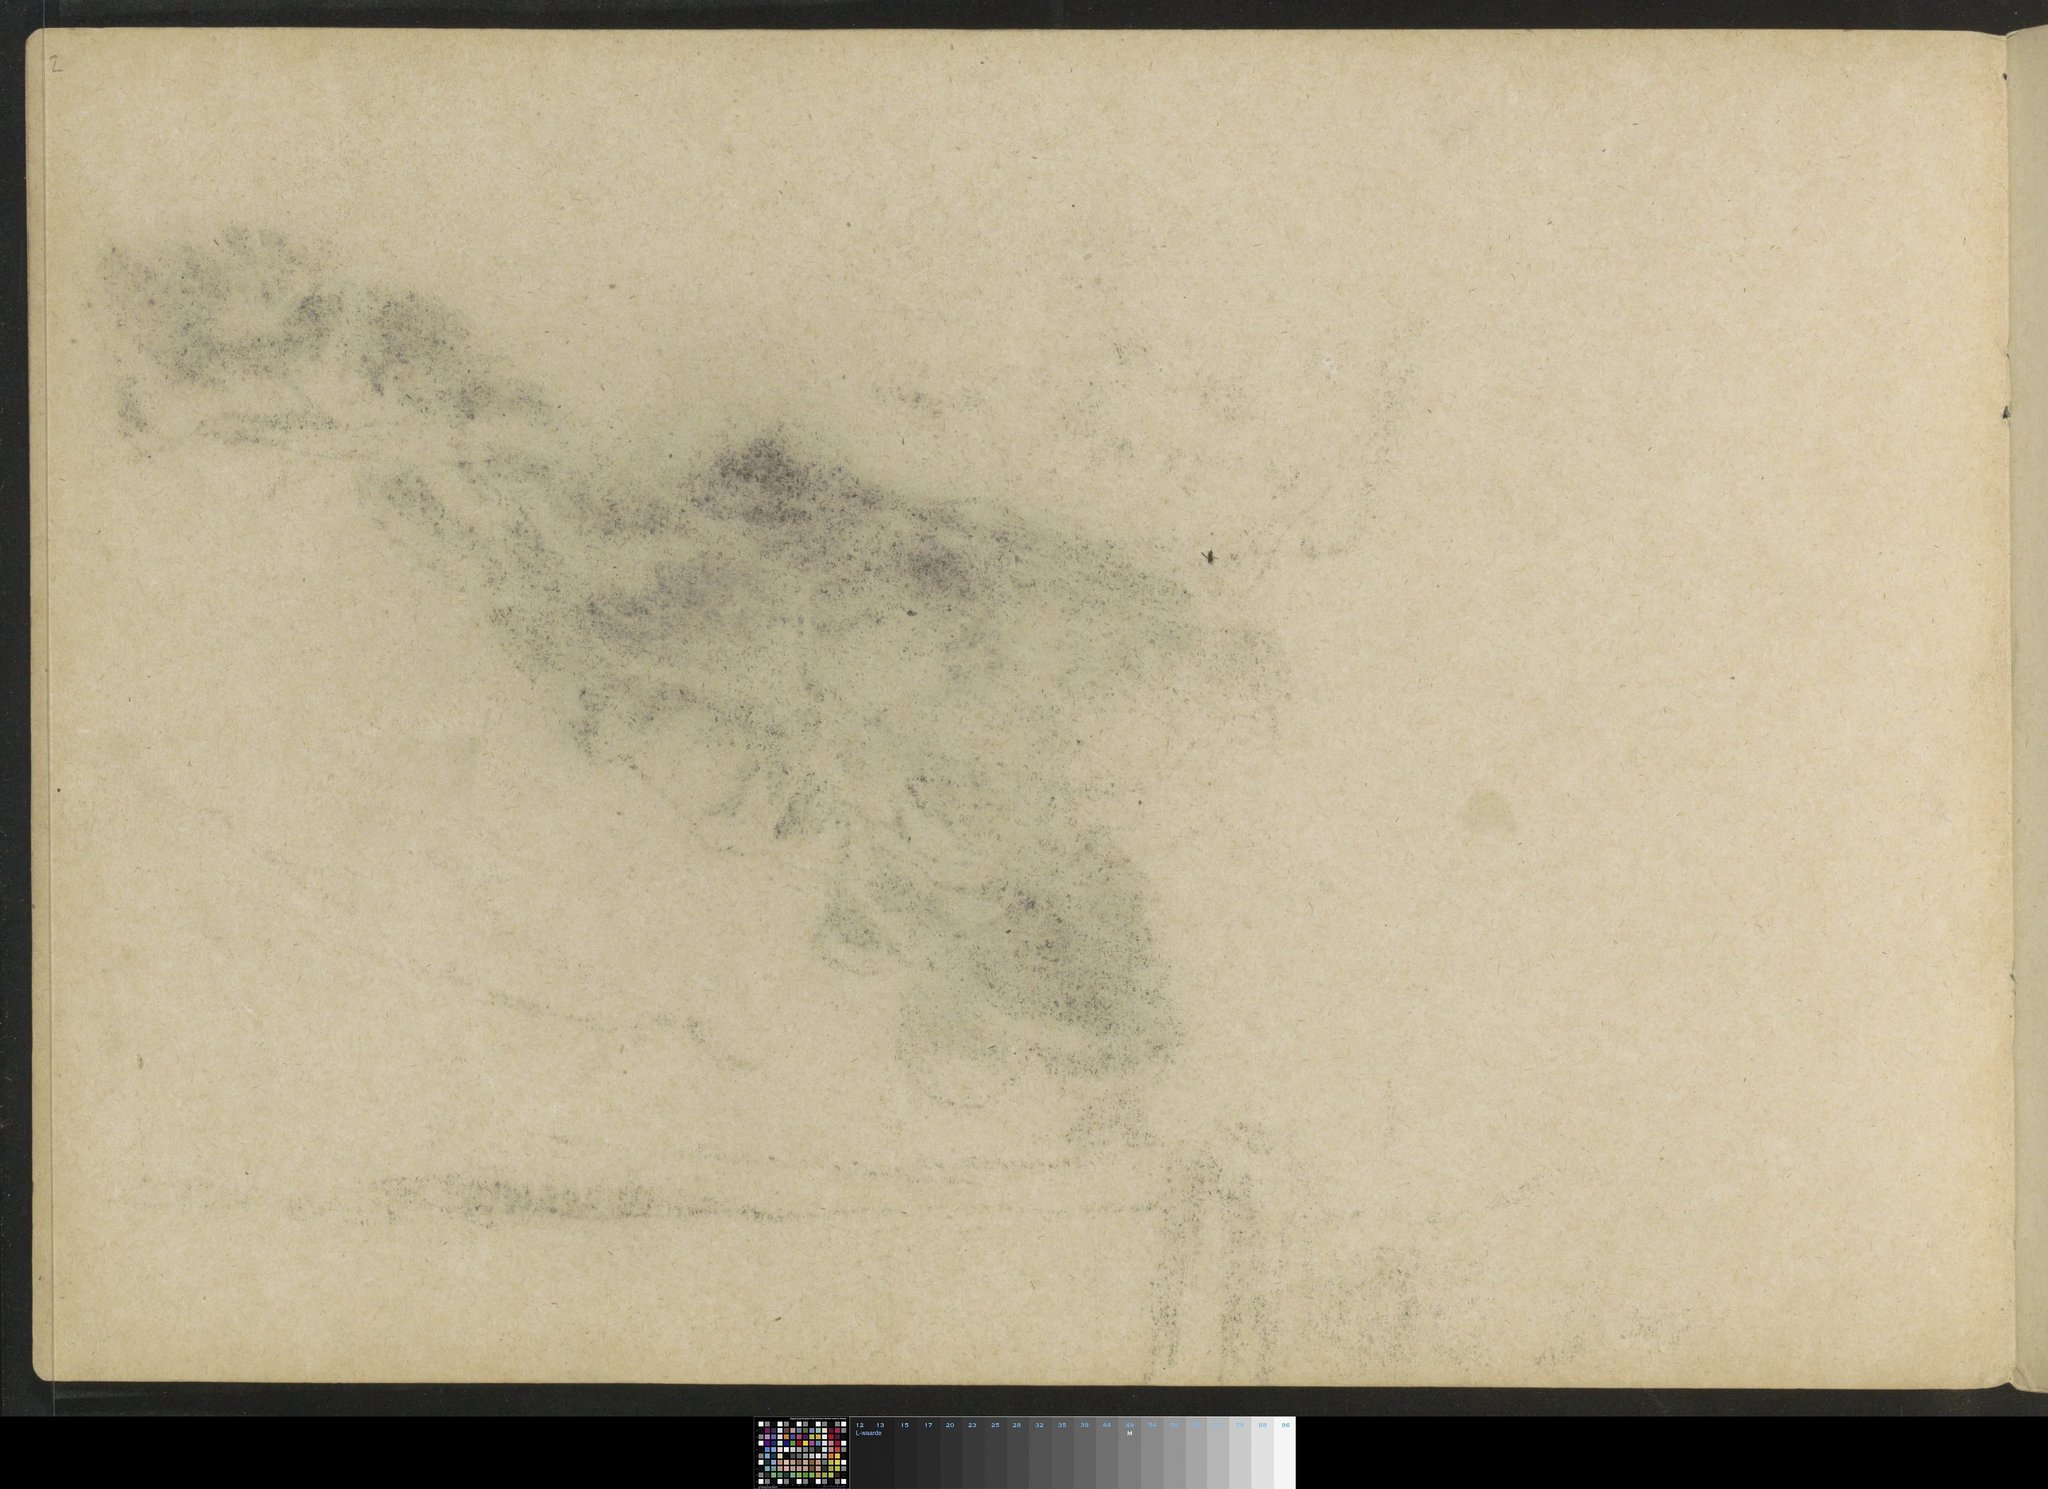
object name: sketchbook leaf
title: Abklatsch van de krijttekening op pagina 3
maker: willem witsen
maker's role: draughtsman, painter, print maker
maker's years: 1860-1923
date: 1884-1887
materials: paper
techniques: printmaking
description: Pagina 2 uit een schetsboek met 29 bladen.